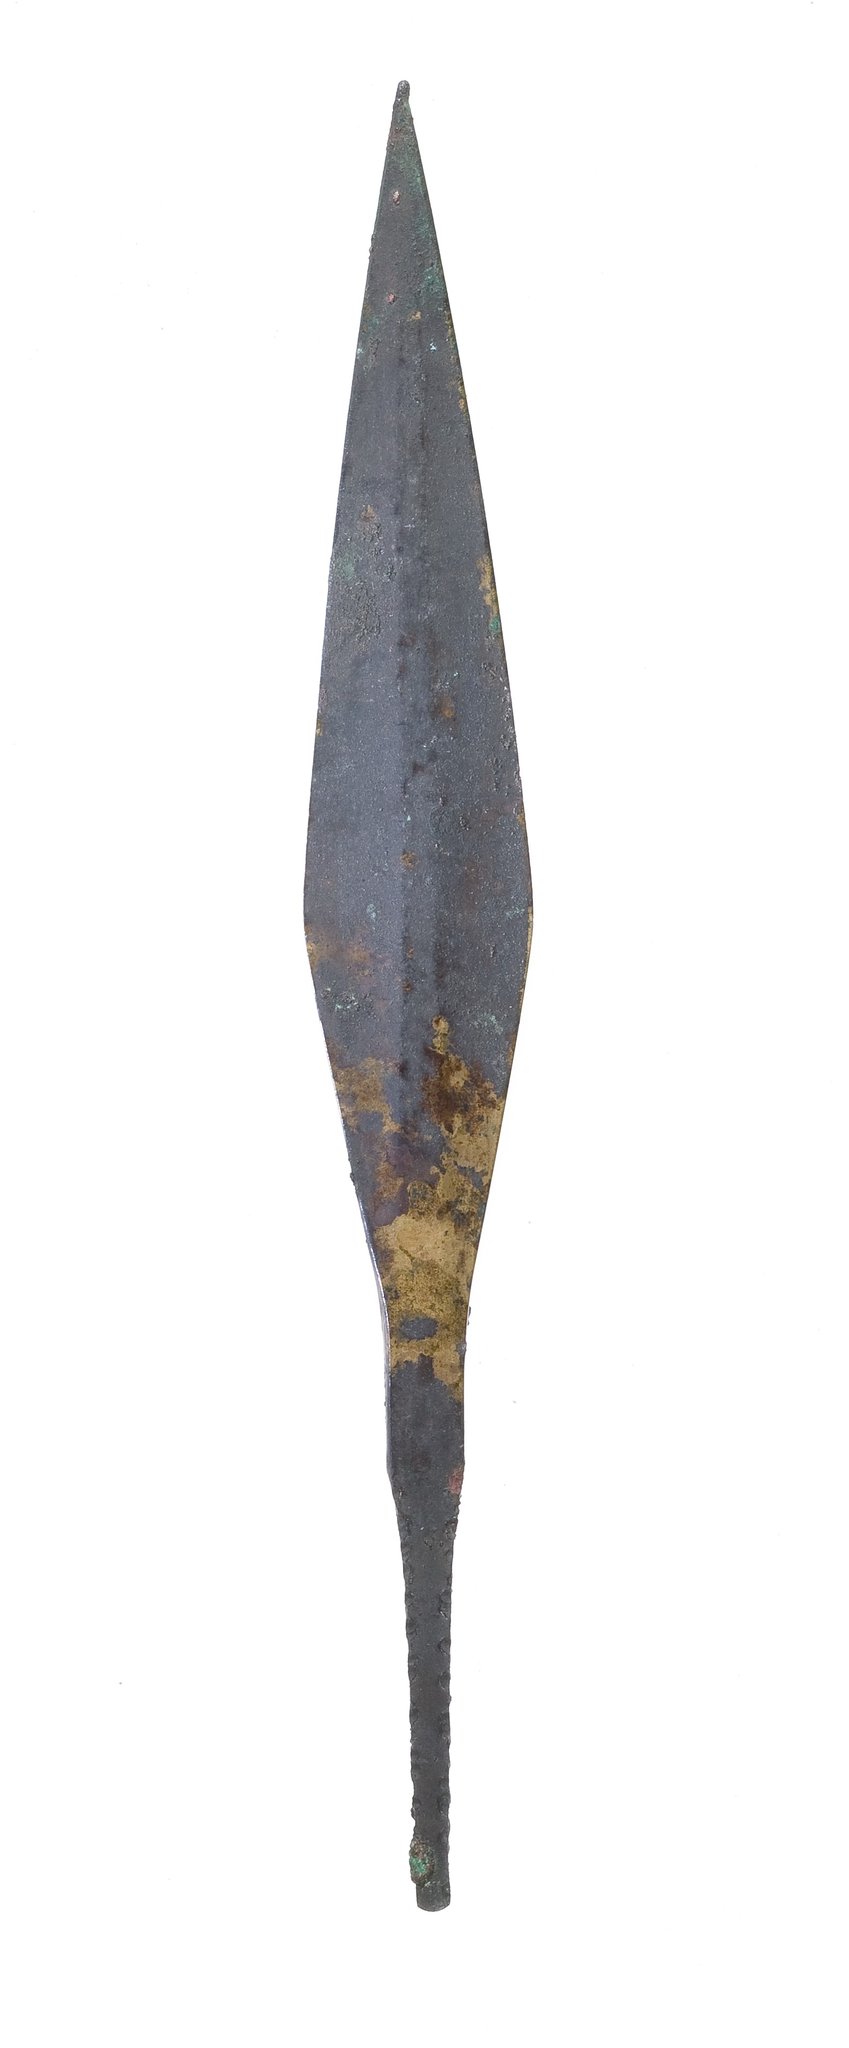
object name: arrowhead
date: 1550-1458 BCE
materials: copper alloy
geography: egypt